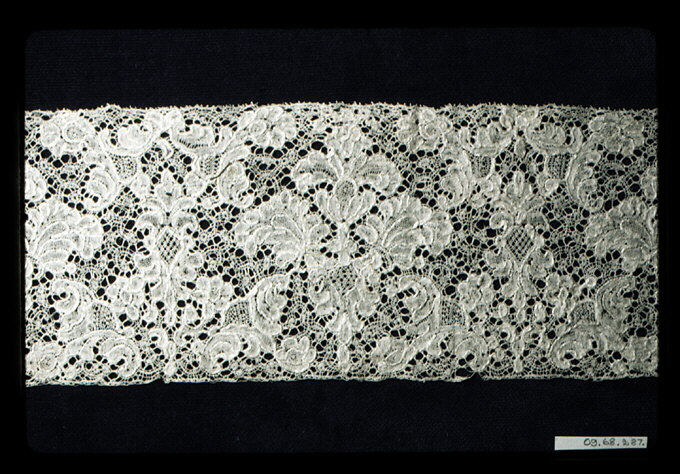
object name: border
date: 1701-1733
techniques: lace